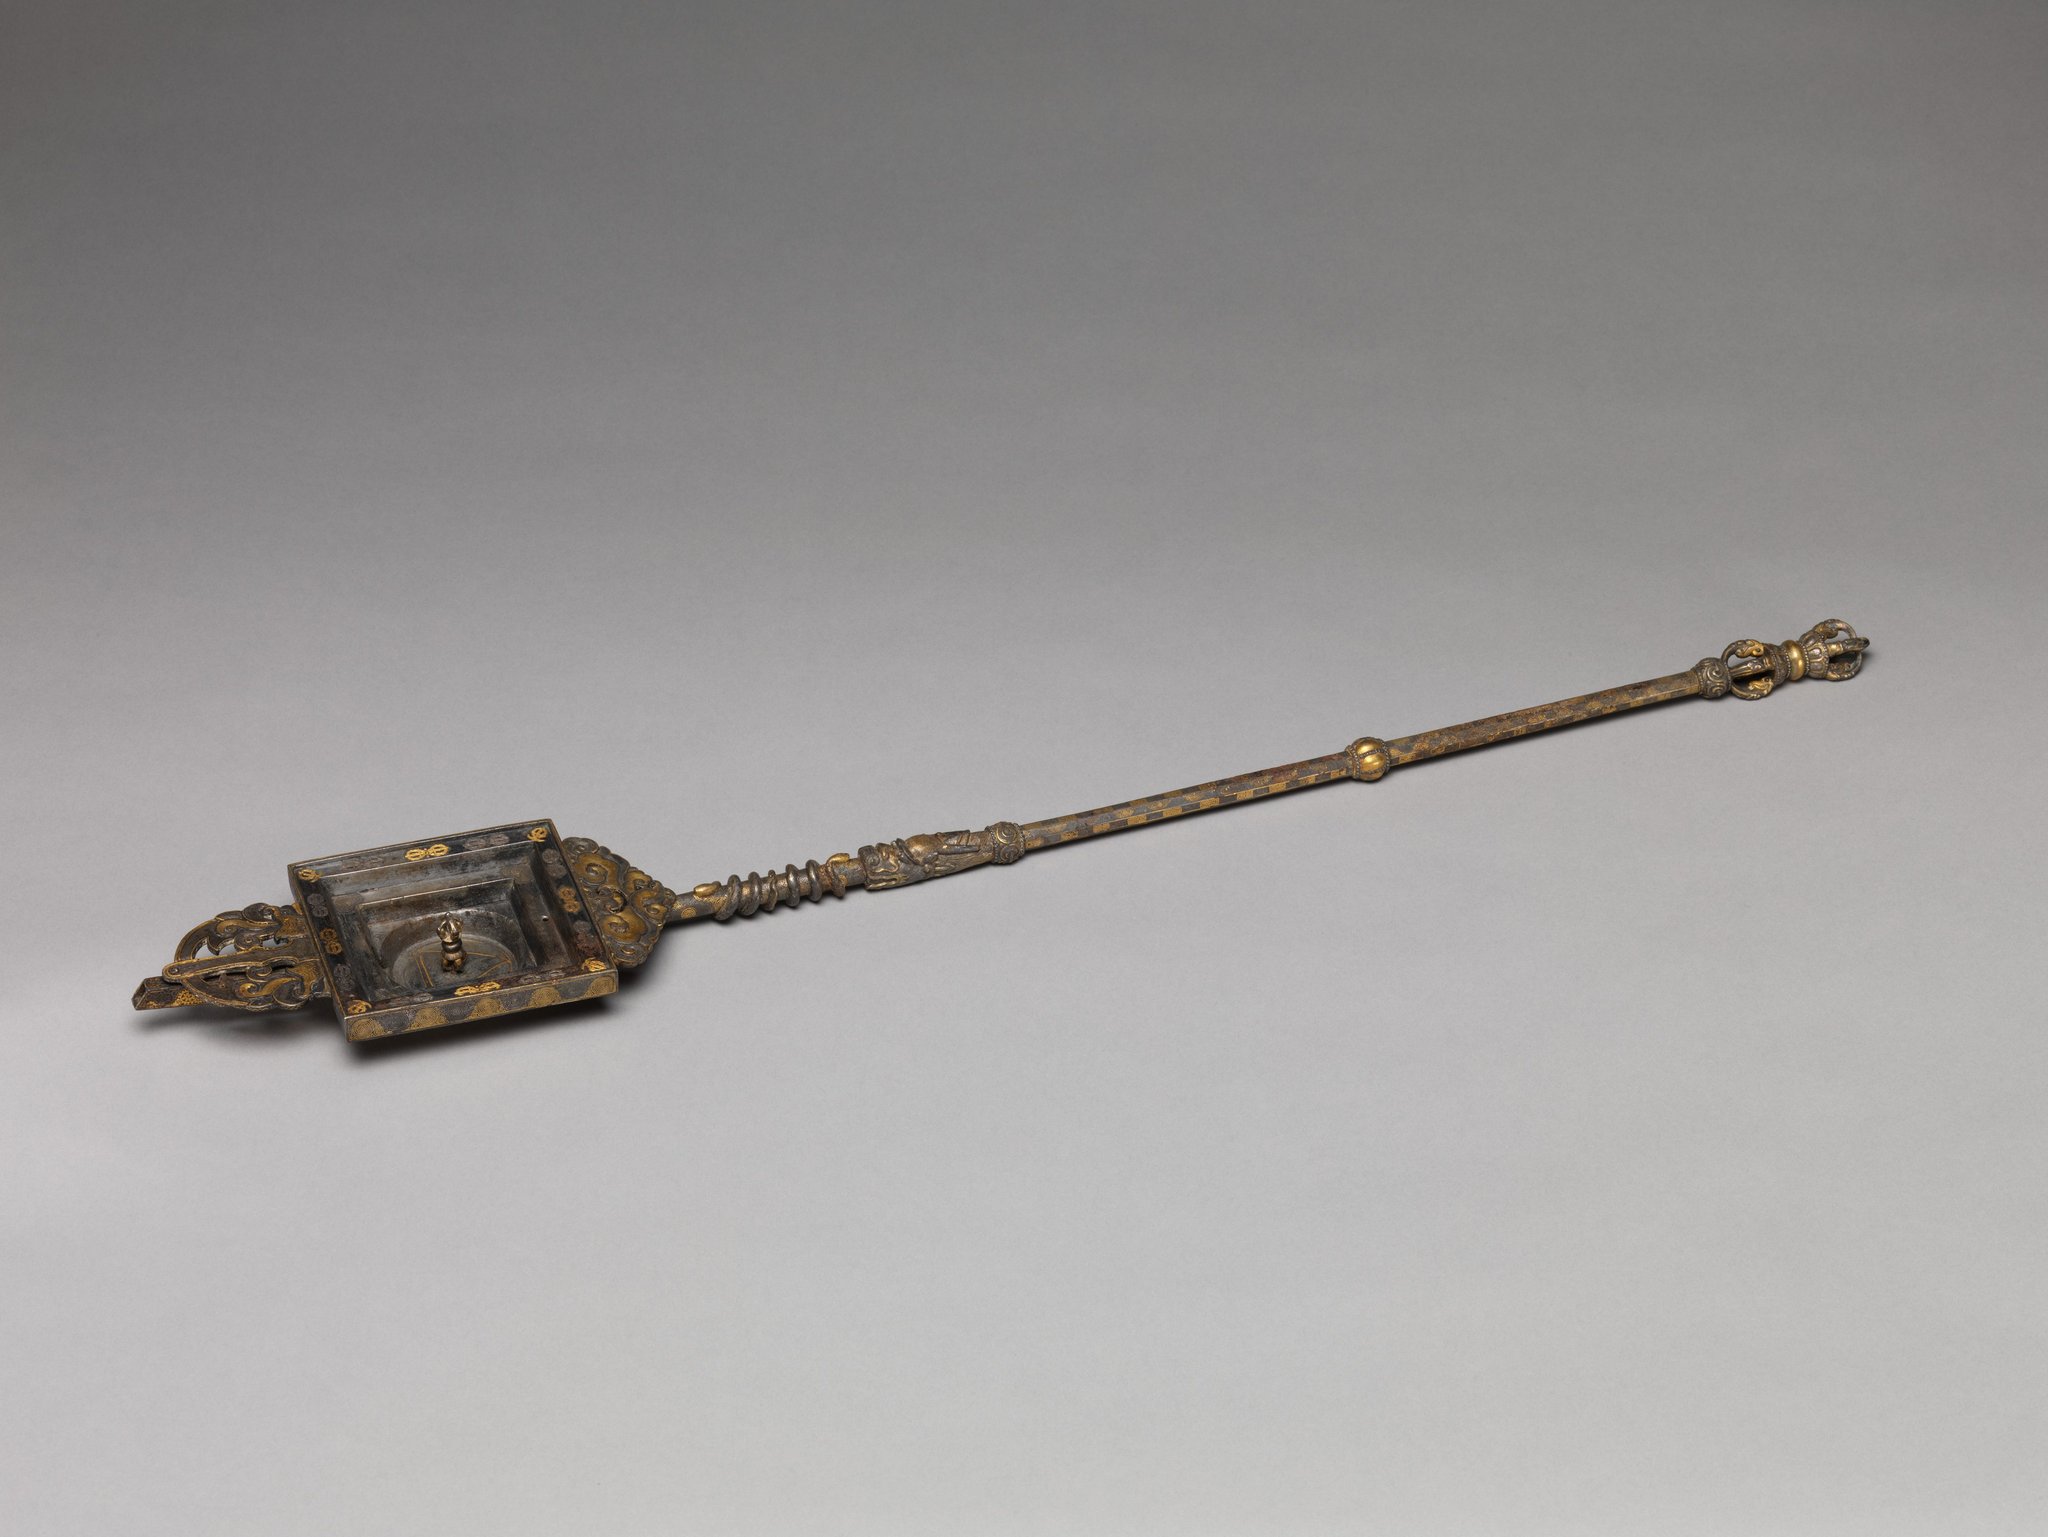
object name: ladle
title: Fire-offering ladle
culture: tibet, eastern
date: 1403-1424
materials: gold, iron, silver